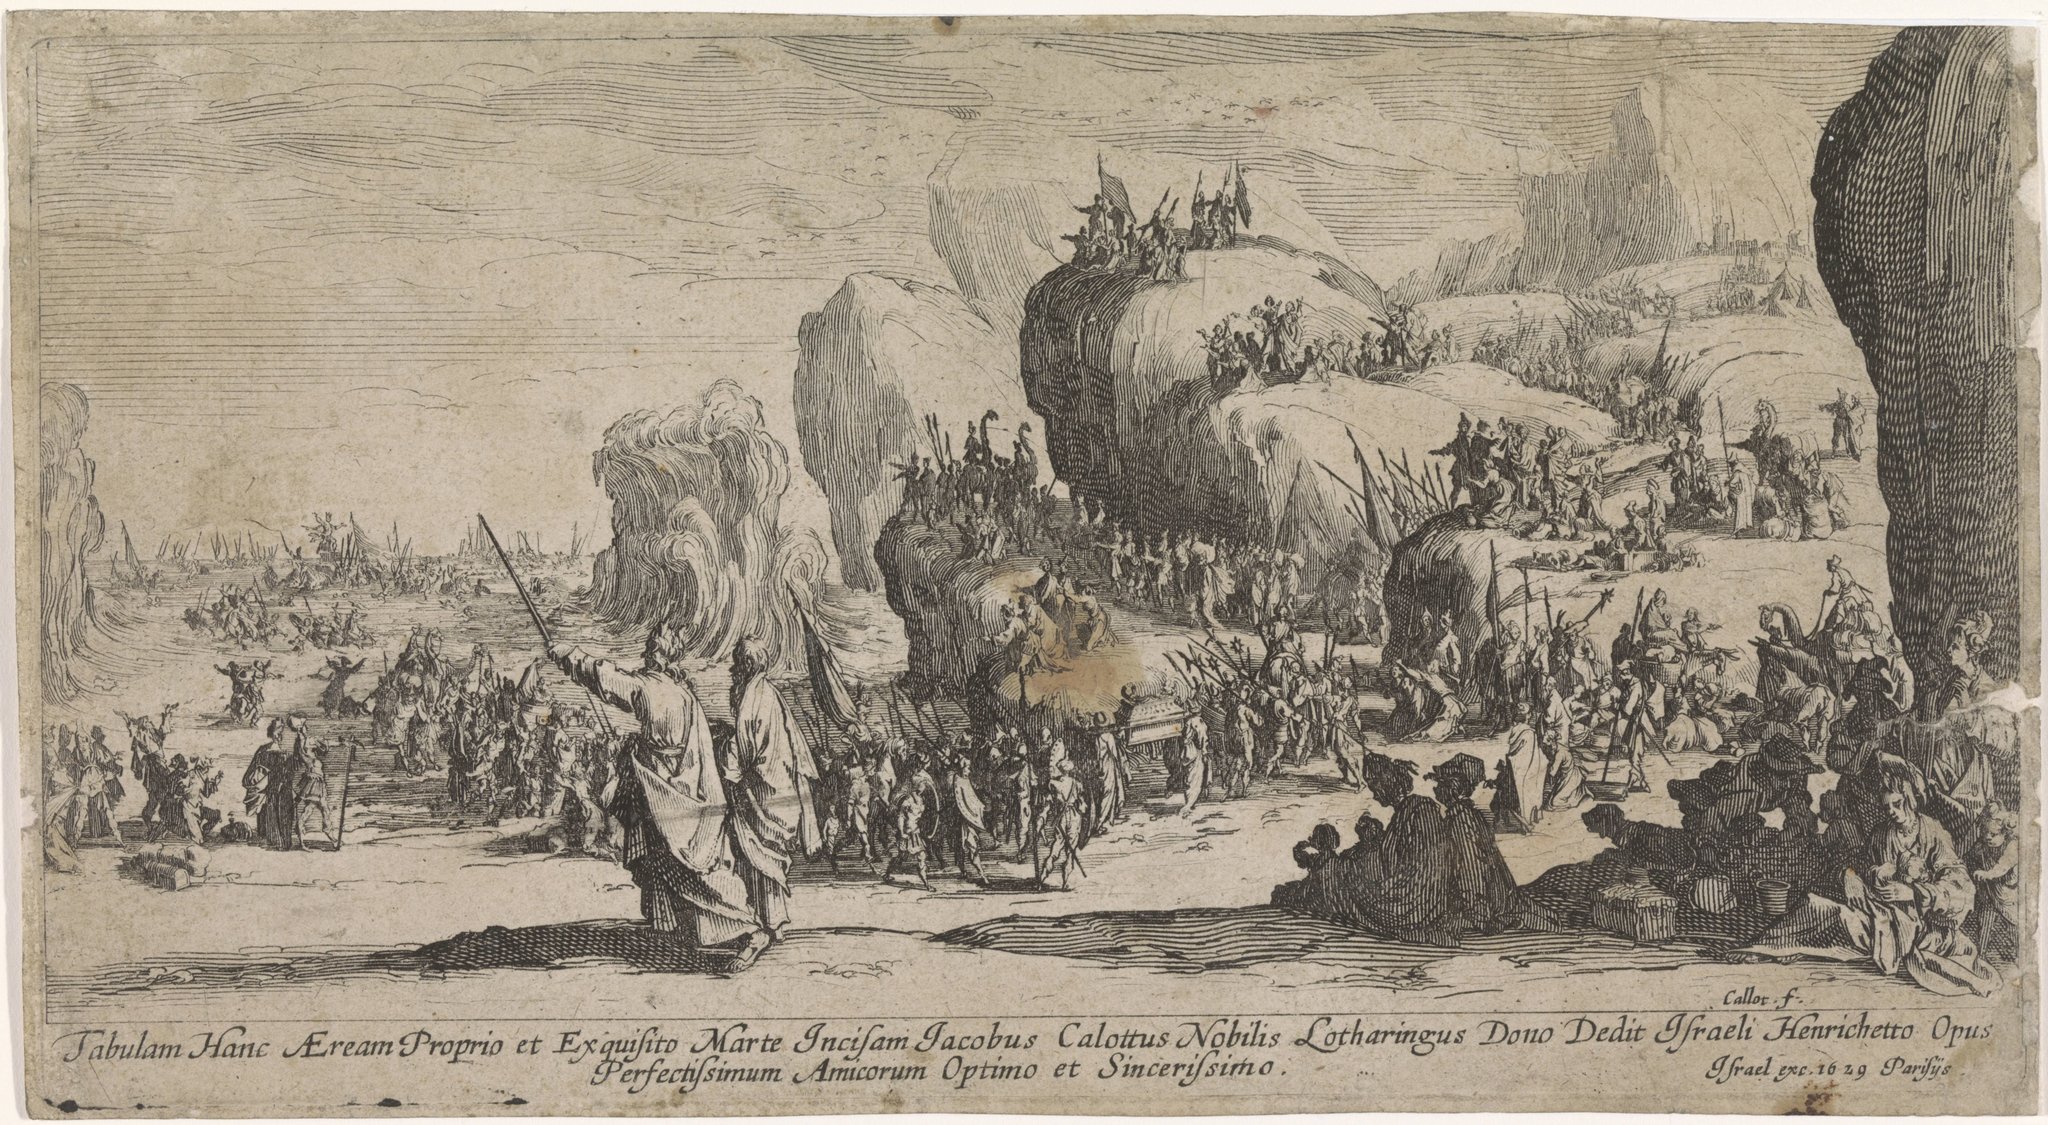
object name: print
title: Doortocht door de Rode Zee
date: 1629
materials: paper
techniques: etching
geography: nancy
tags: with his people safe on the shore, moses raises his hands and causes the water to return; pharaoh's army perishes in the water (red sea)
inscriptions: collector's mark: Lugt 2228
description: Op de voorgrond staan Mozes en Aäron, eerstgenoemde met een staf in de geheven linkerhand. Voor hen langs trekken de Israëlieten tussen de geweken golven van de Schelfzee (een uitloper van de Rode Zee) door en verder door de bergen. Links op de achtergrond is te zien hoe de farao met zijn gevolg verzwolgen wordt door het terugvloeiende water. Onder de voorstelling twee regels Latijnse tekst.